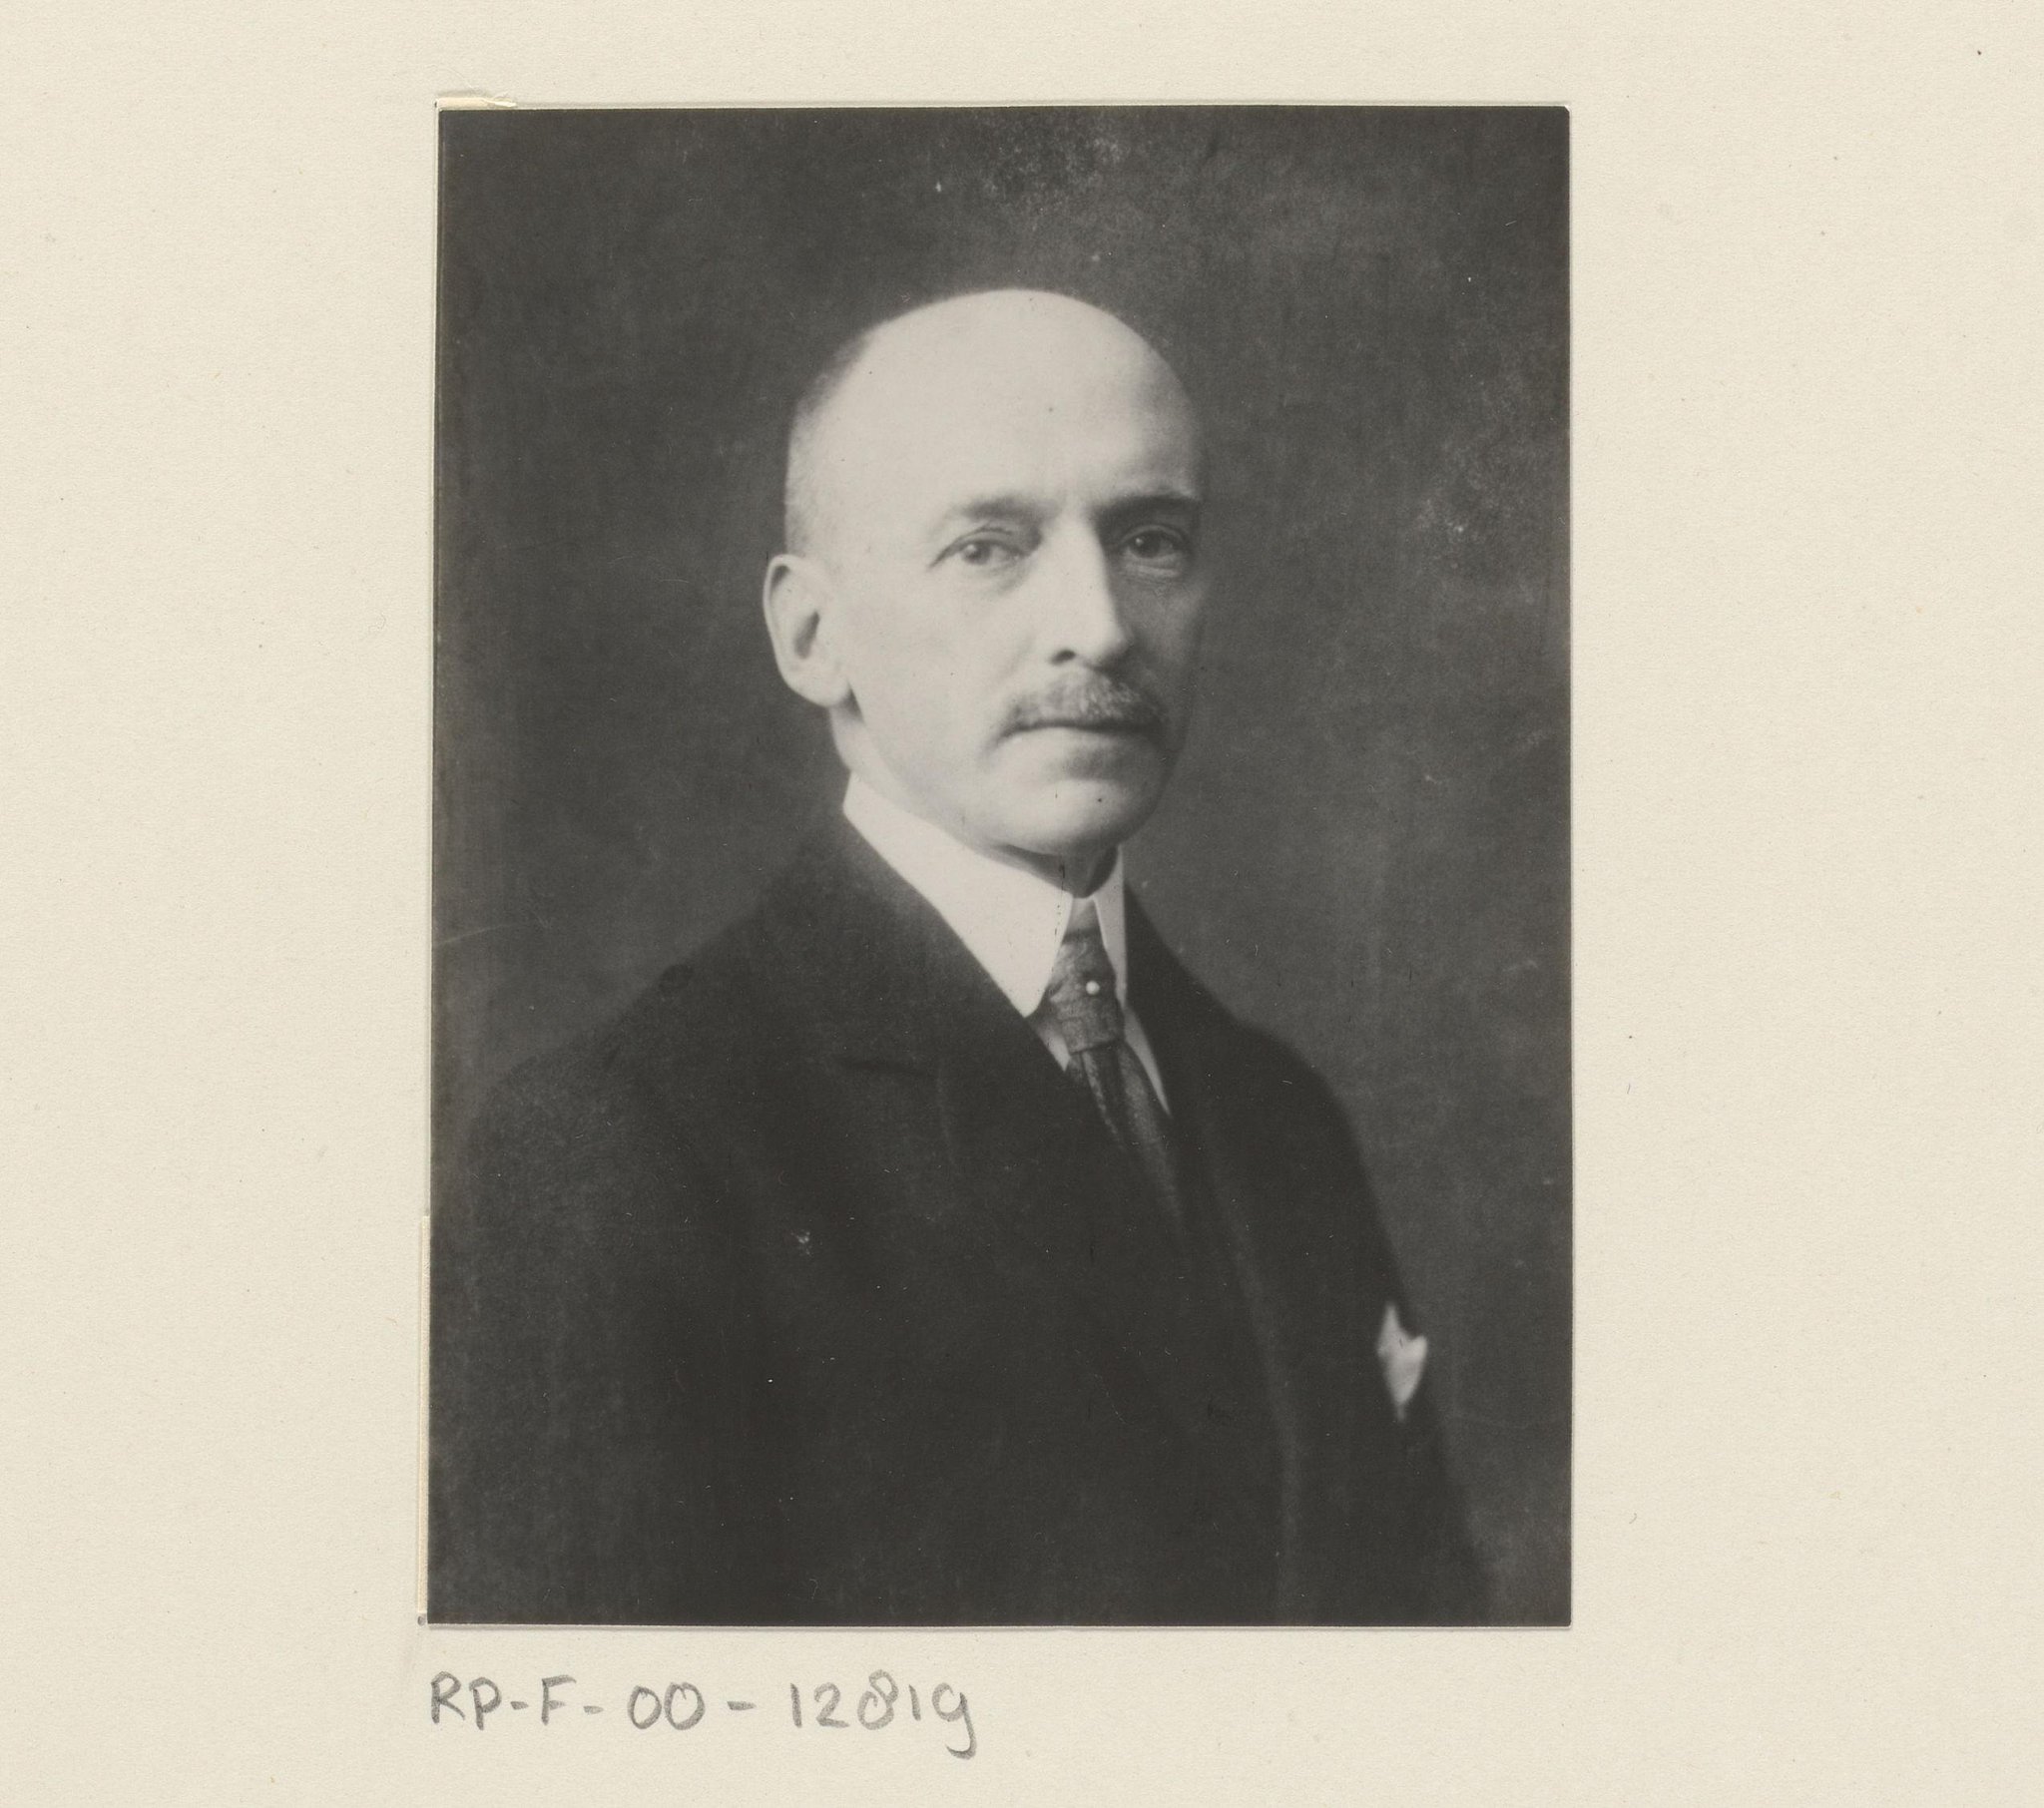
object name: photograph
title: Portret van Anton van Doorninck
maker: Anonymous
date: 1910-1940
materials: paper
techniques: gelatin silver print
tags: historical persons, portrait of a writer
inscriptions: inscription: ‘Mr Dr A van Door/ninck/ Thesaurier-gen-/dep v Fin/ s Hage’